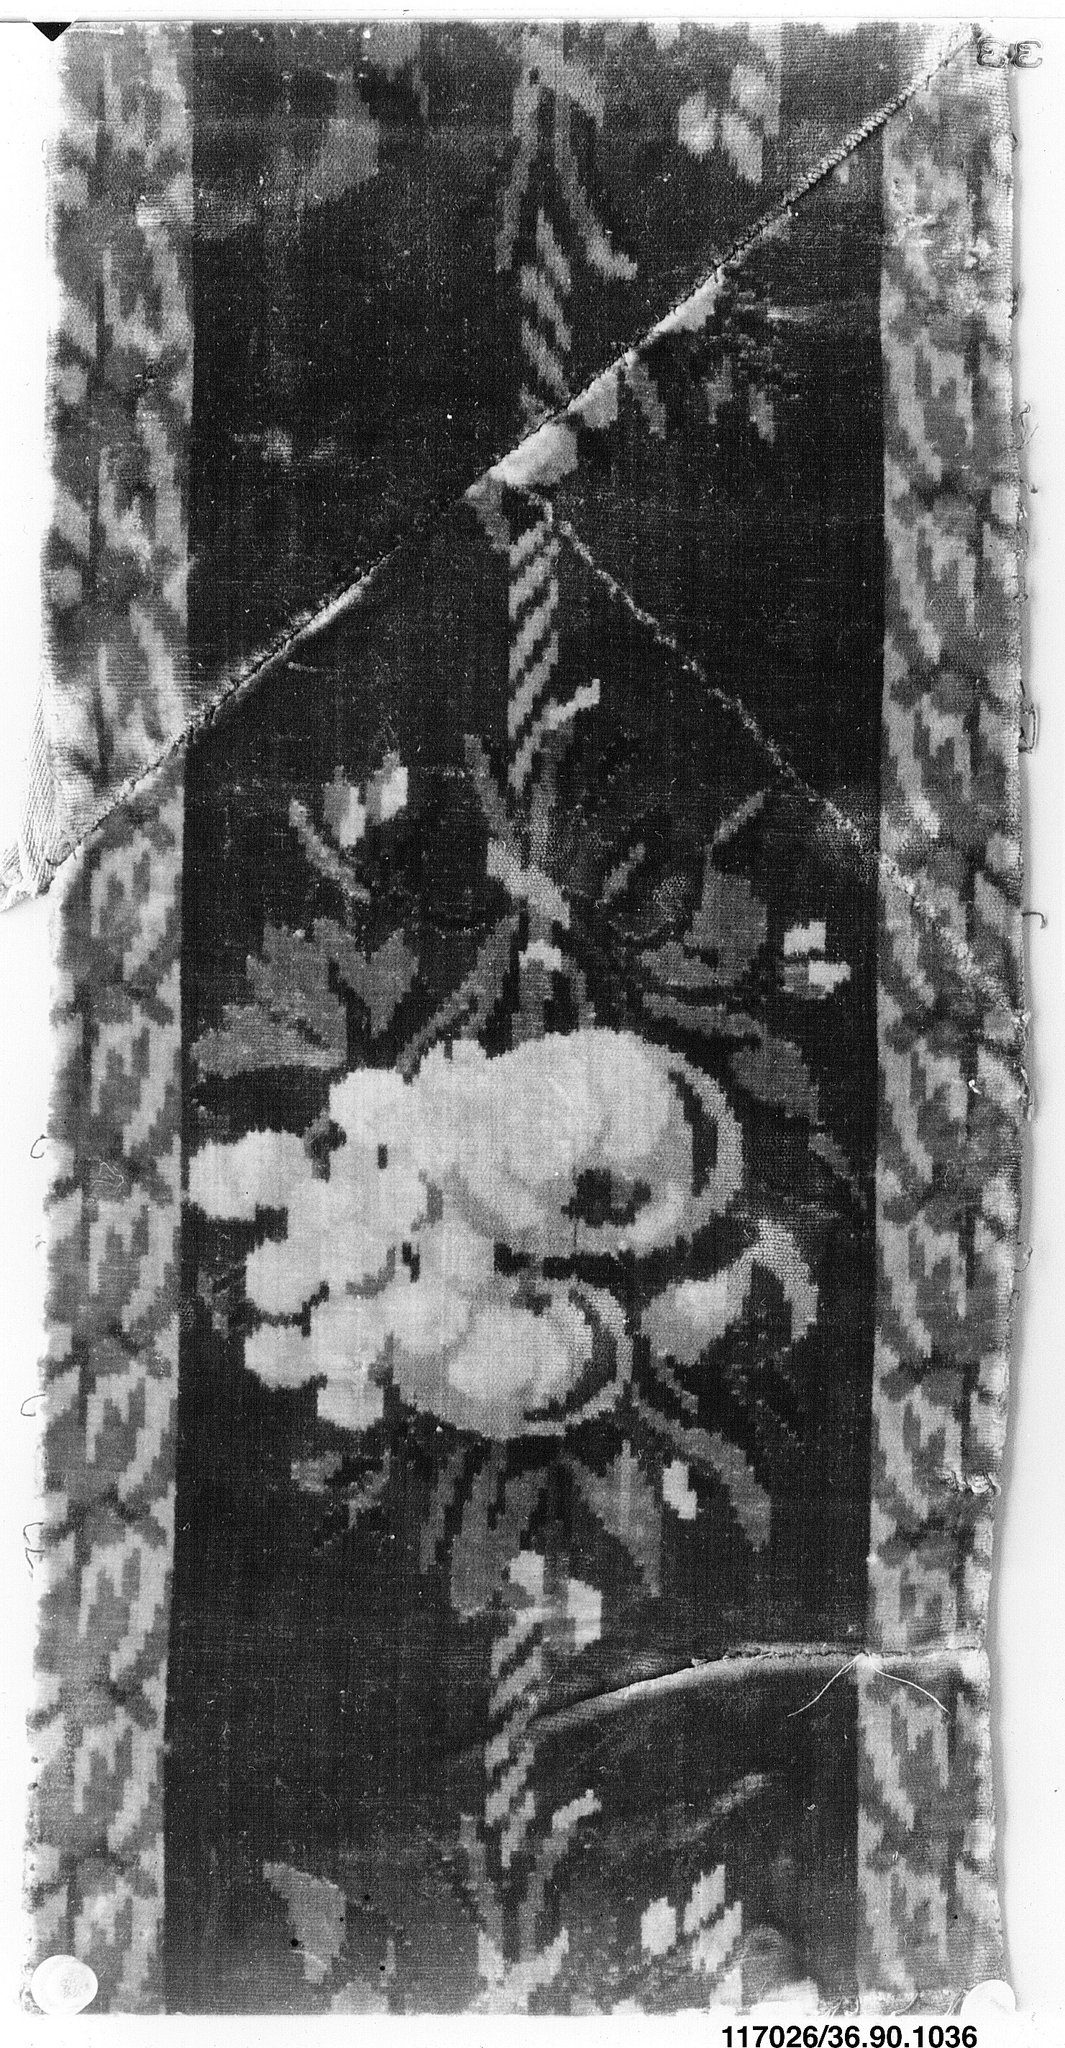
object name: border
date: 1801-1900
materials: silk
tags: fruit